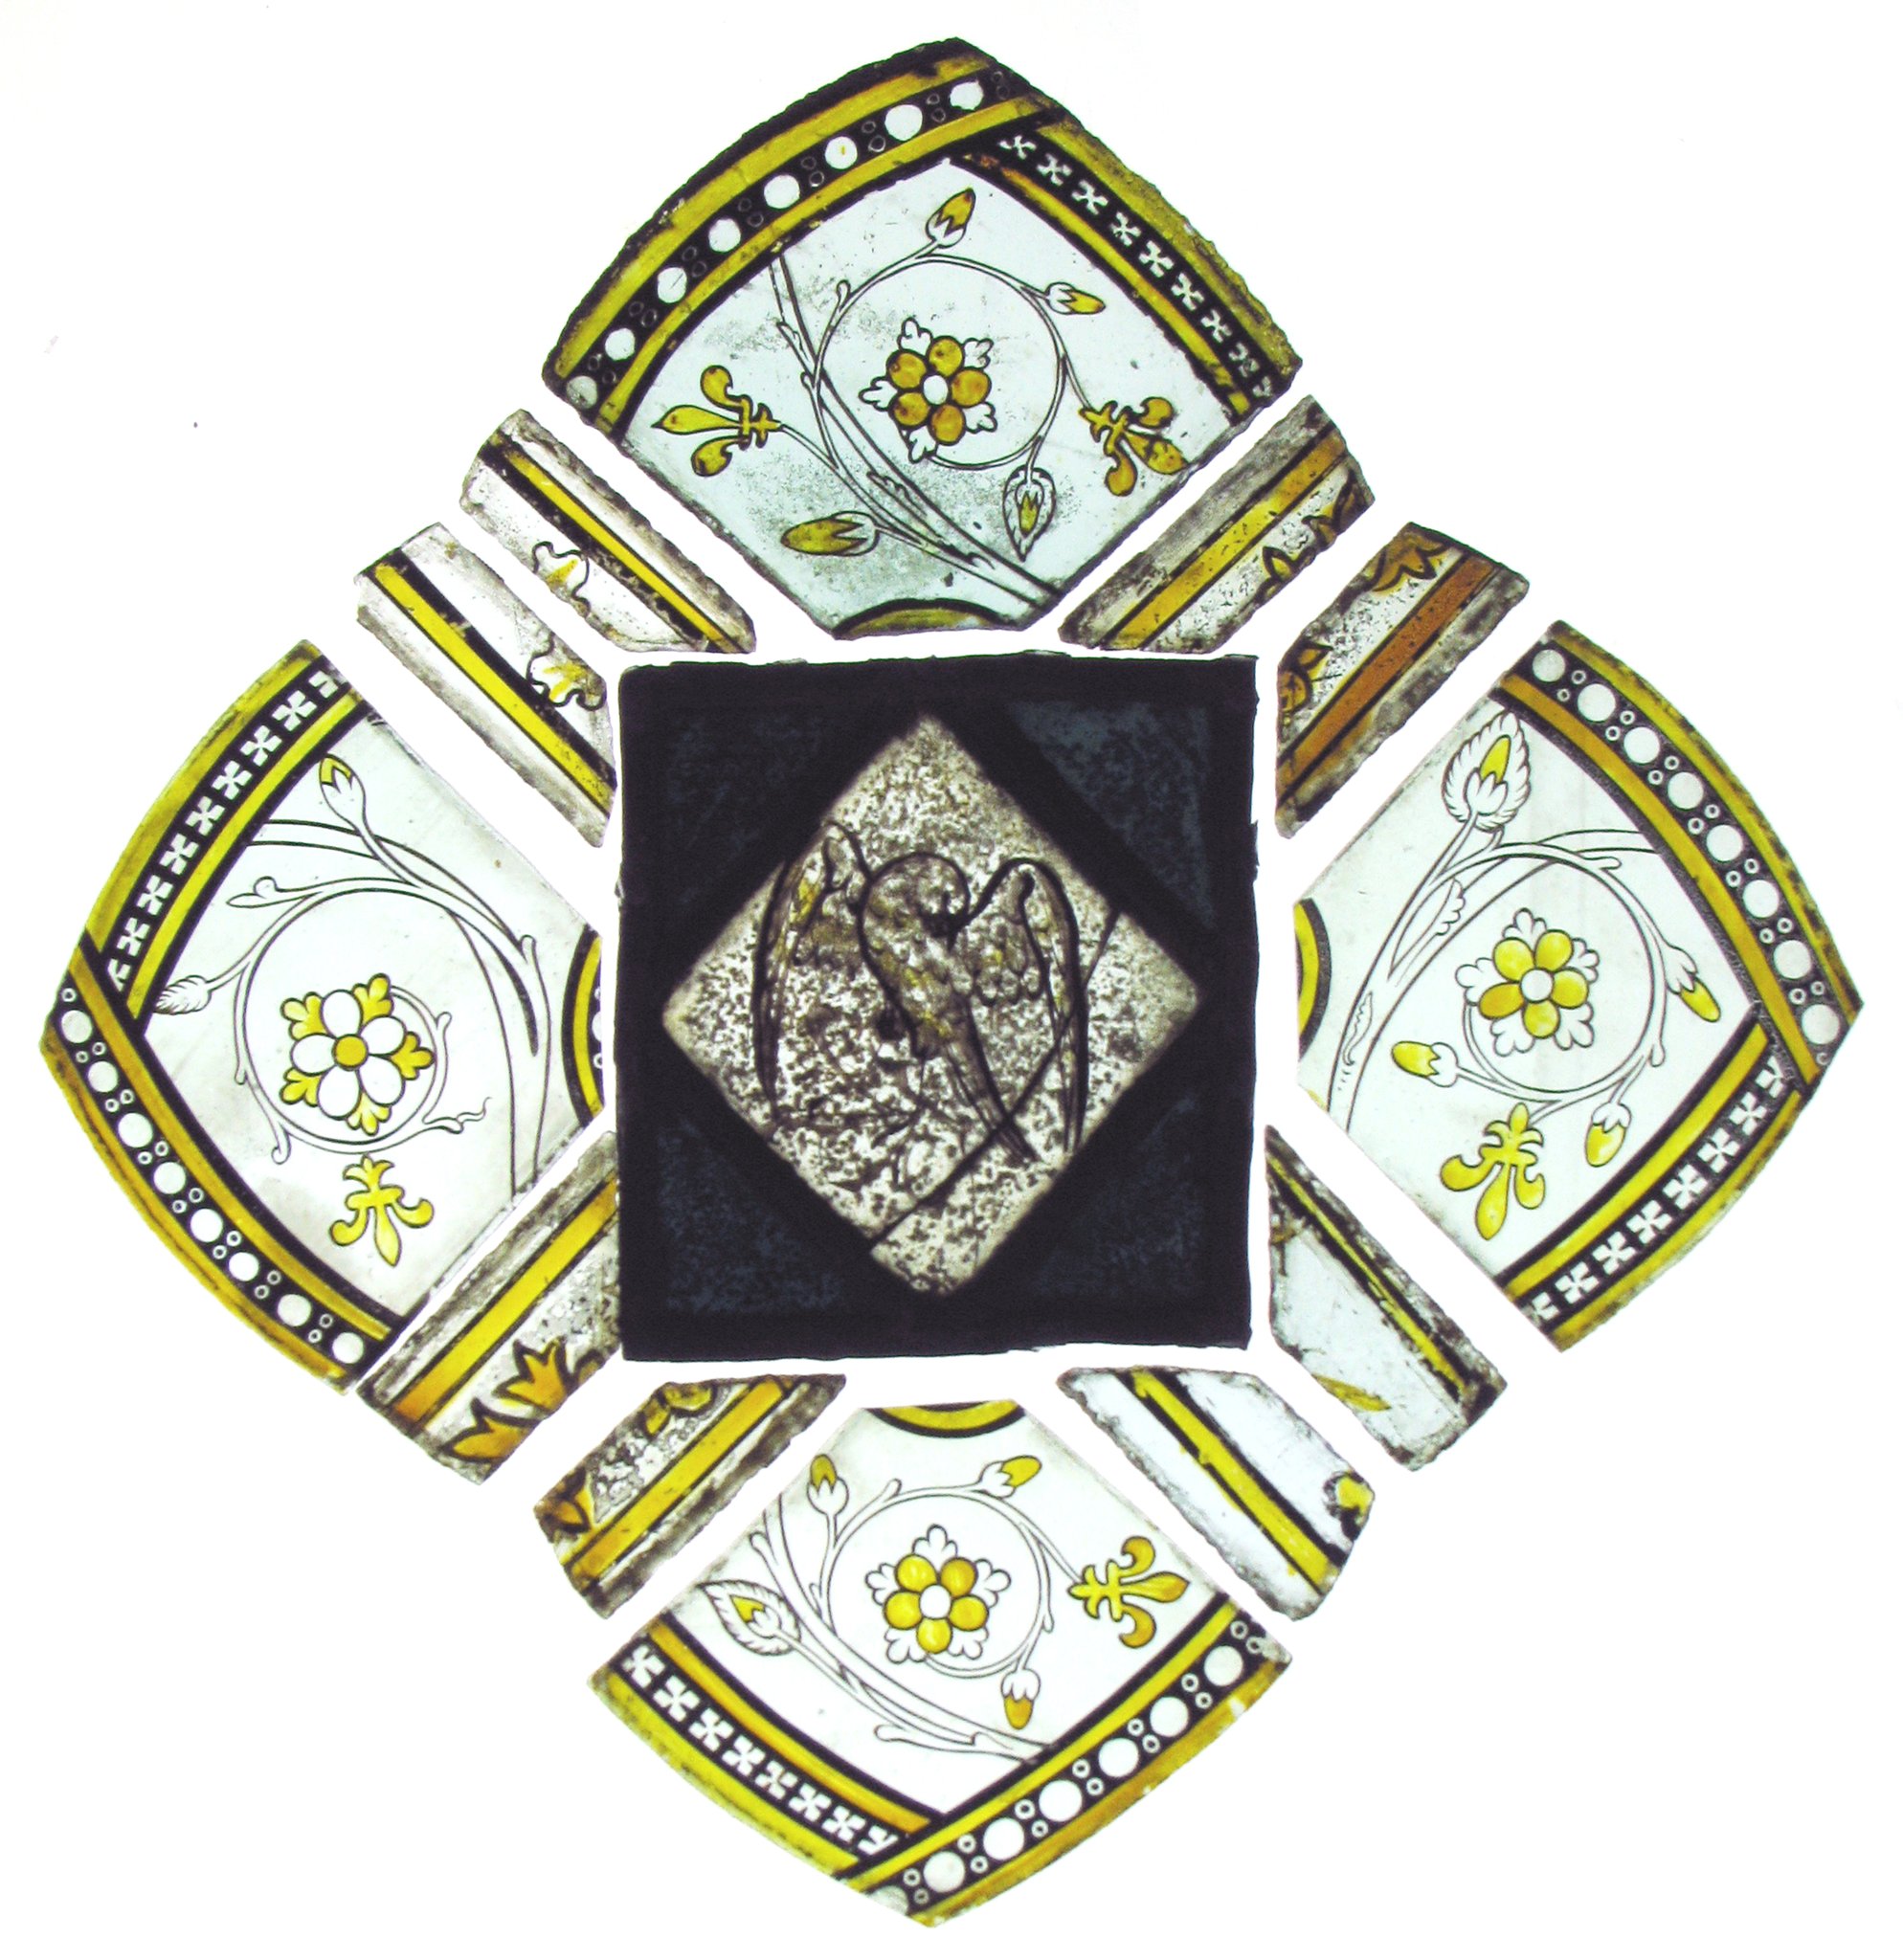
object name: stained glass panel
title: Grisaille Quarries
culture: french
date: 1320-1324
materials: glass, metal, pigment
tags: flowers